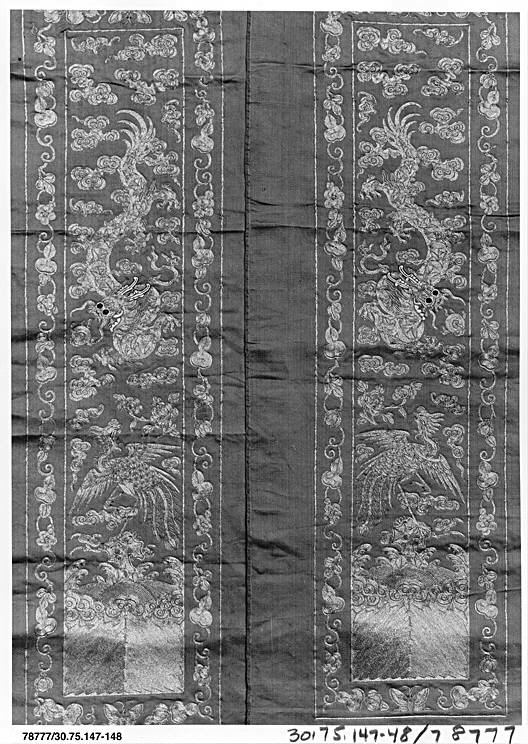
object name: sleeve band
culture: chinese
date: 1801-1900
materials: metal thread, silk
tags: birds